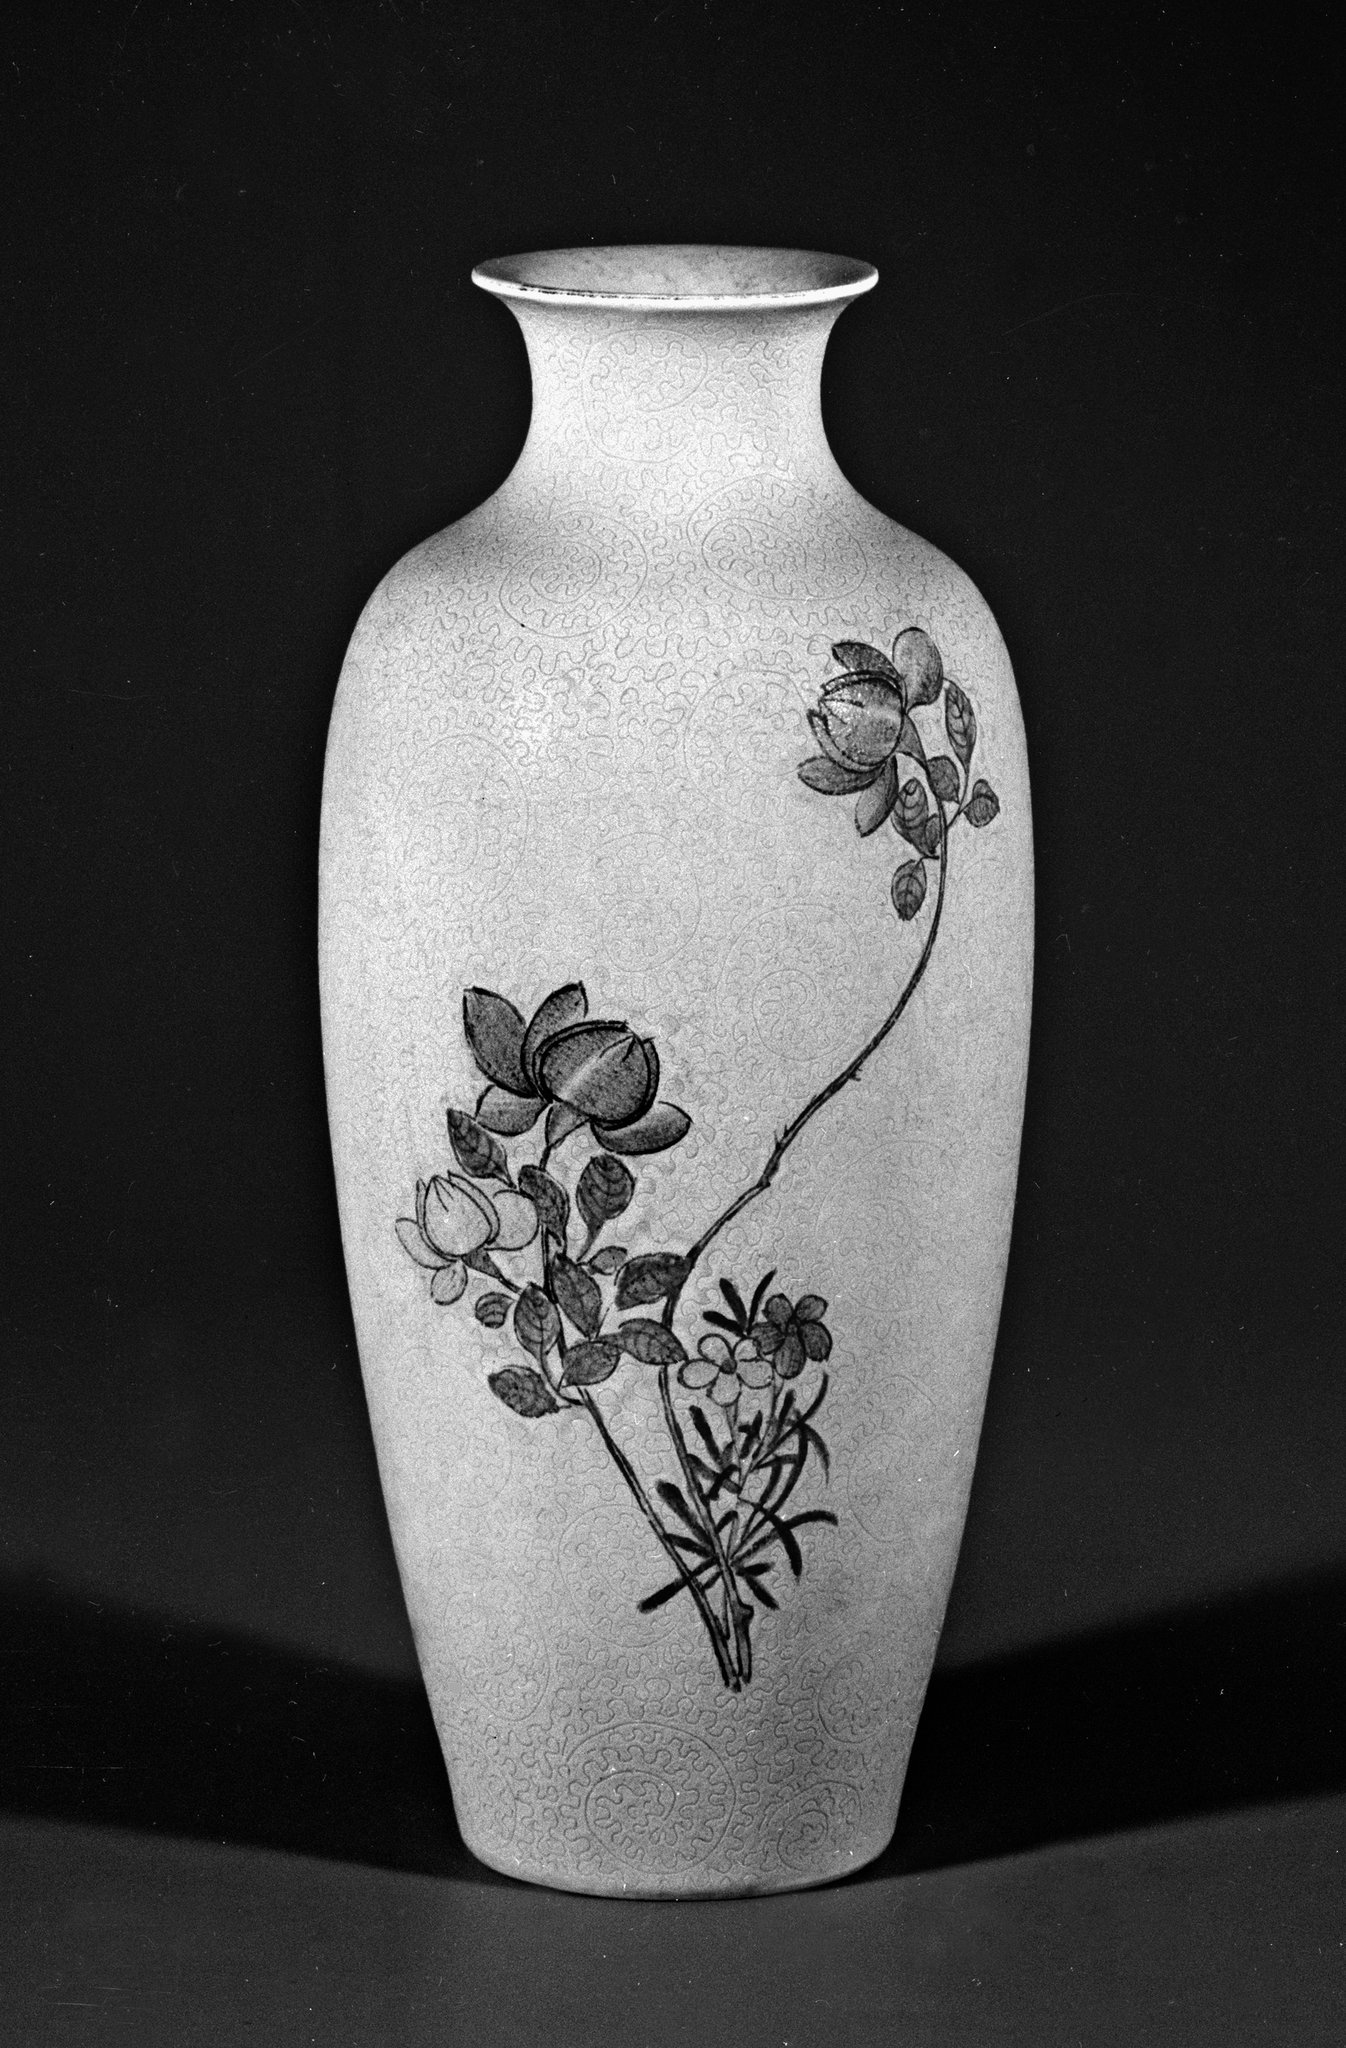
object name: vase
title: Vase with flowers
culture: chinese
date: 1801-1900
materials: enamel, porcelain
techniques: overglaze, painting, polychrome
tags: flowers